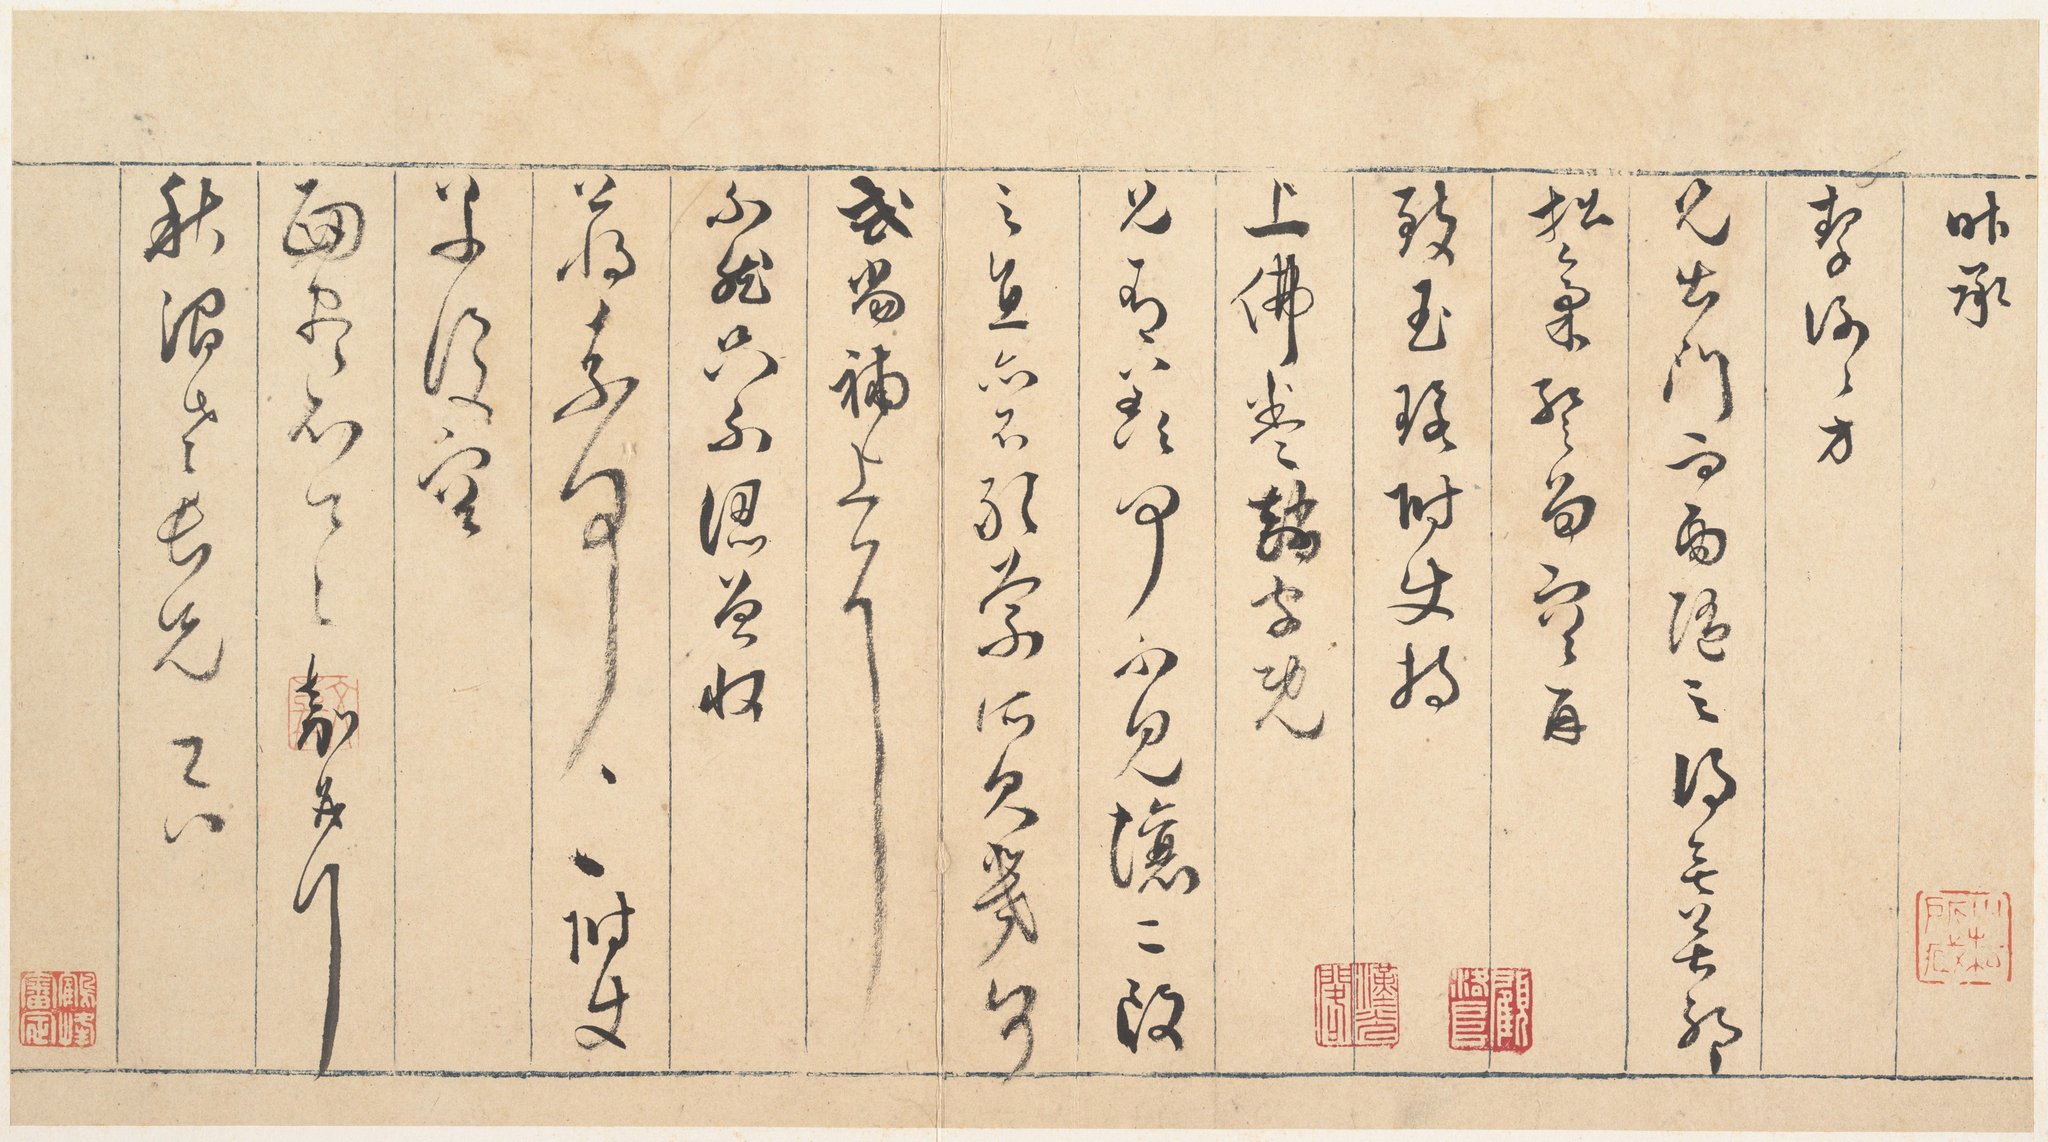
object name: album leaf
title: Letter to Yao Zhi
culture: chinese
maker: wen jia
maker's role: artist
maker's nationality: chinese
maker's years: 1501-1583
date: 1501-1583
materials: ink, paper